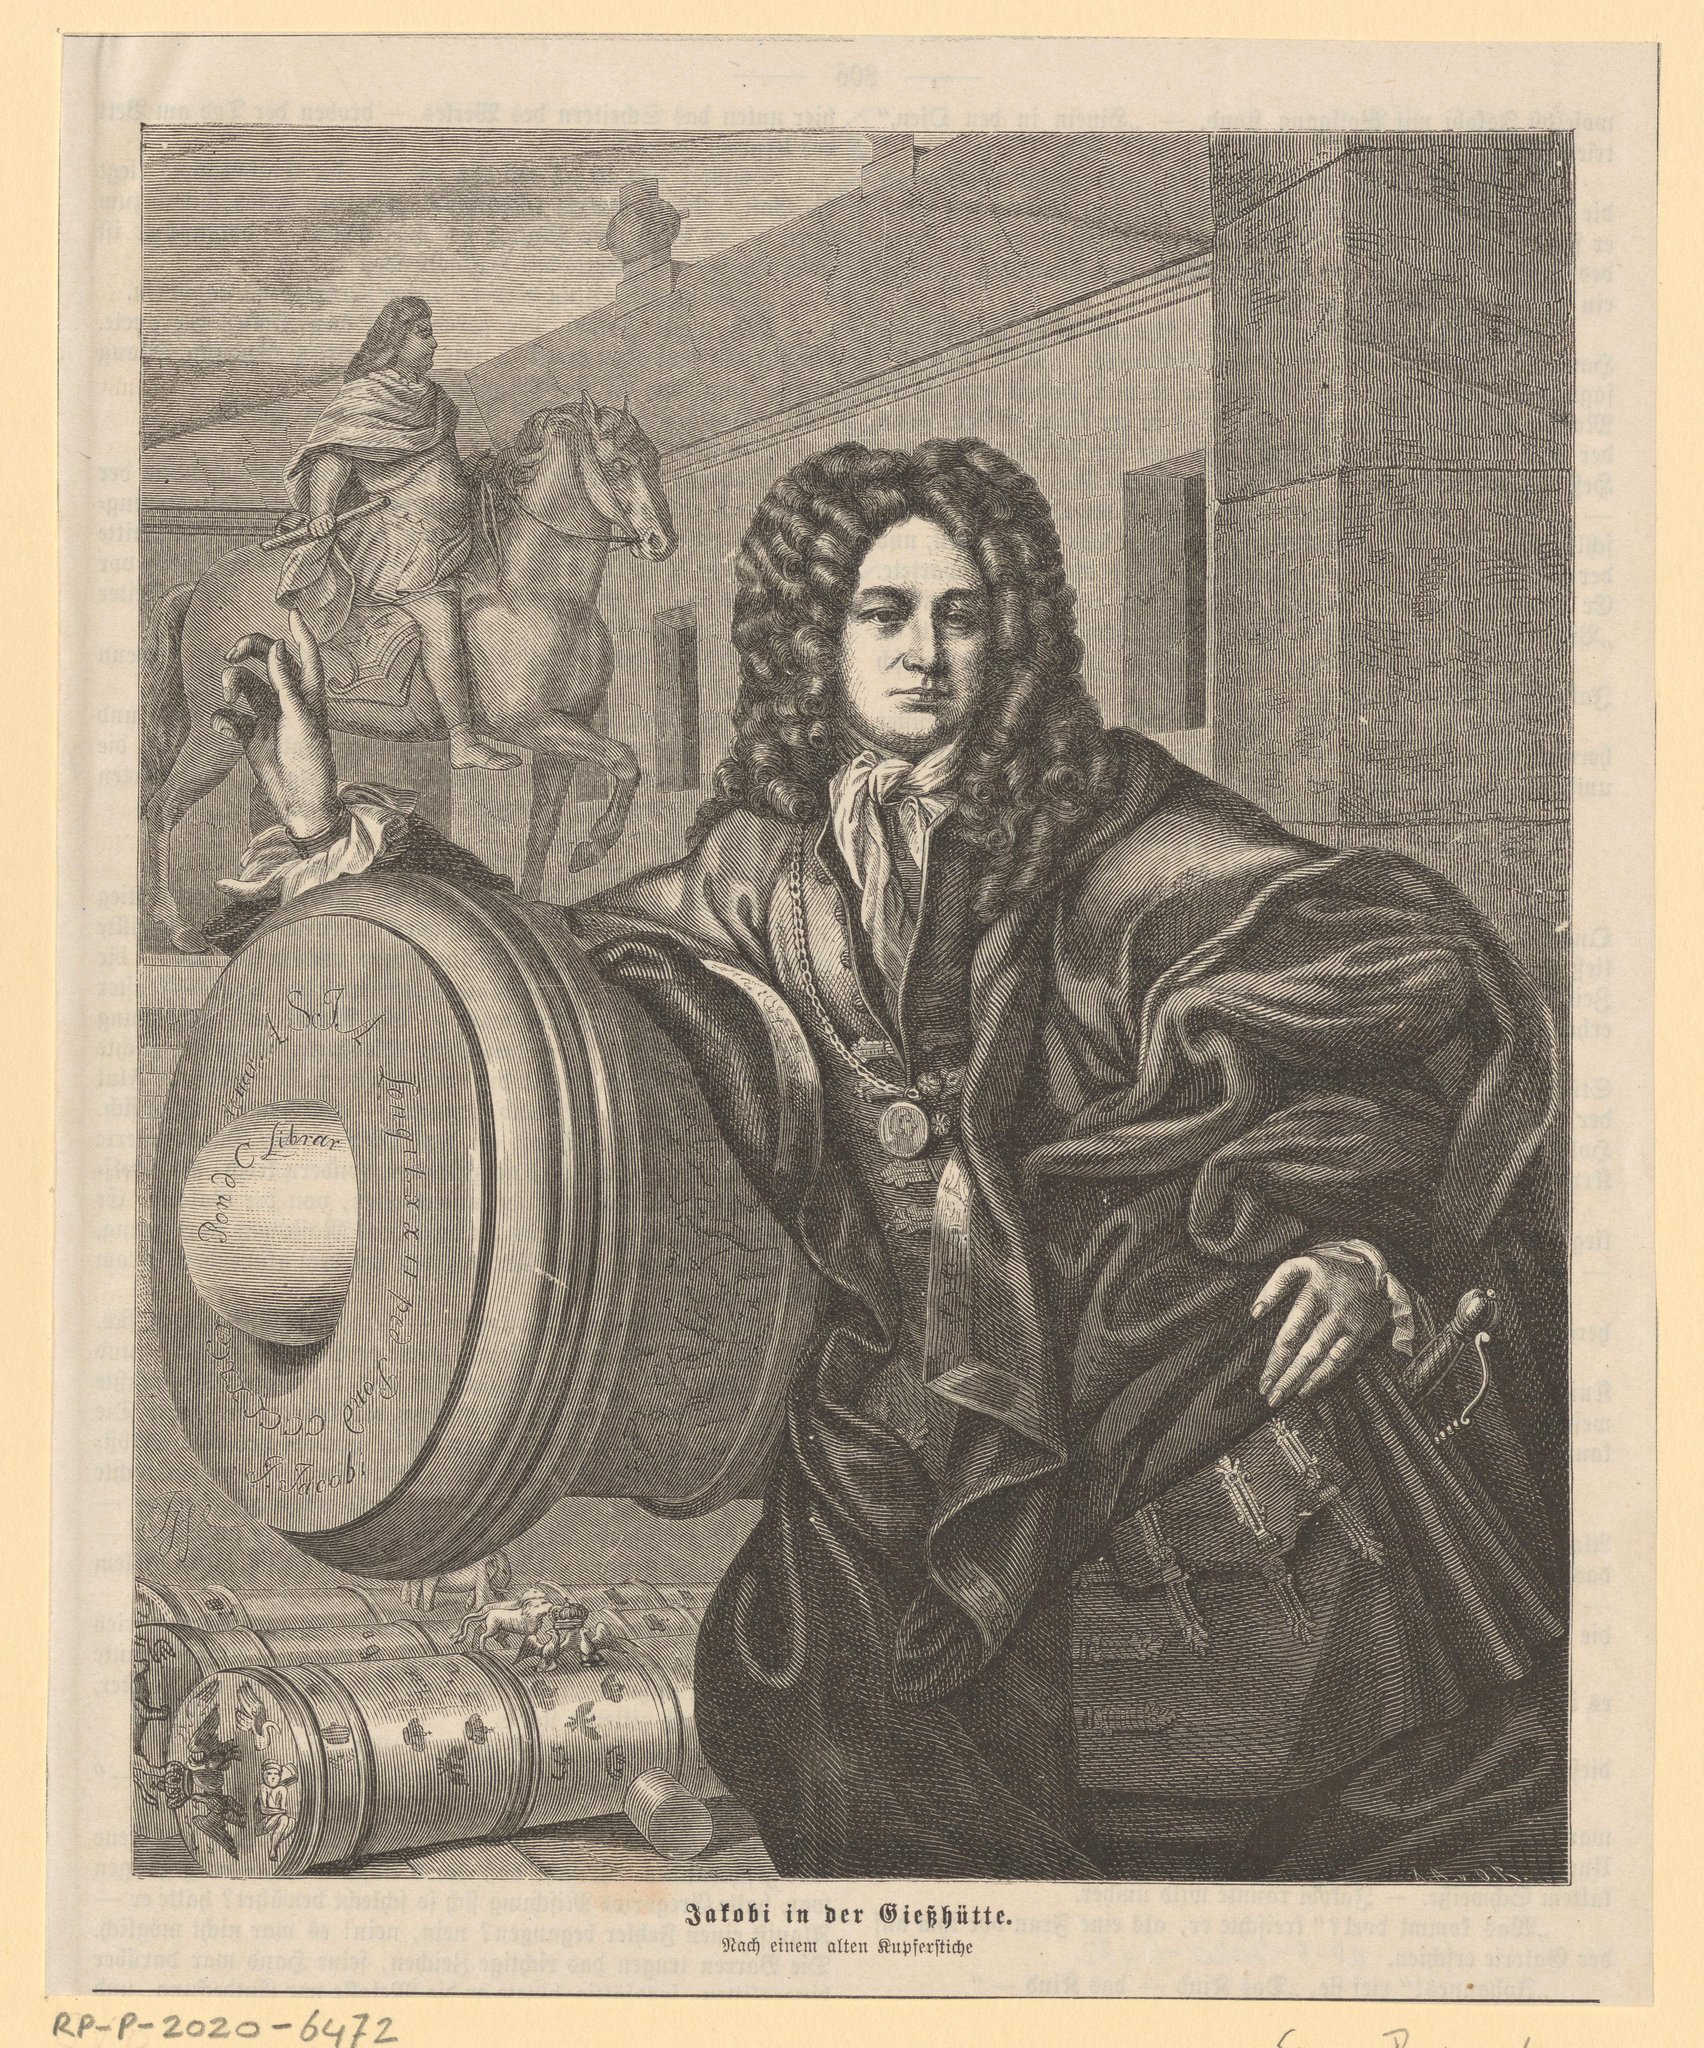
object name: print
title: Portret van Johannes Jacobi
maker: otto roth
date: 1871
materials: paper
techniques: letterpress printing, engraving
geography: leipzig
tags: berlin, caster, historical persons, casting weapons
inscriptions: stamp: ‘JVB’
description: Prent uit: Daheim 7 (1871), nr. 51, 16 september 1871.